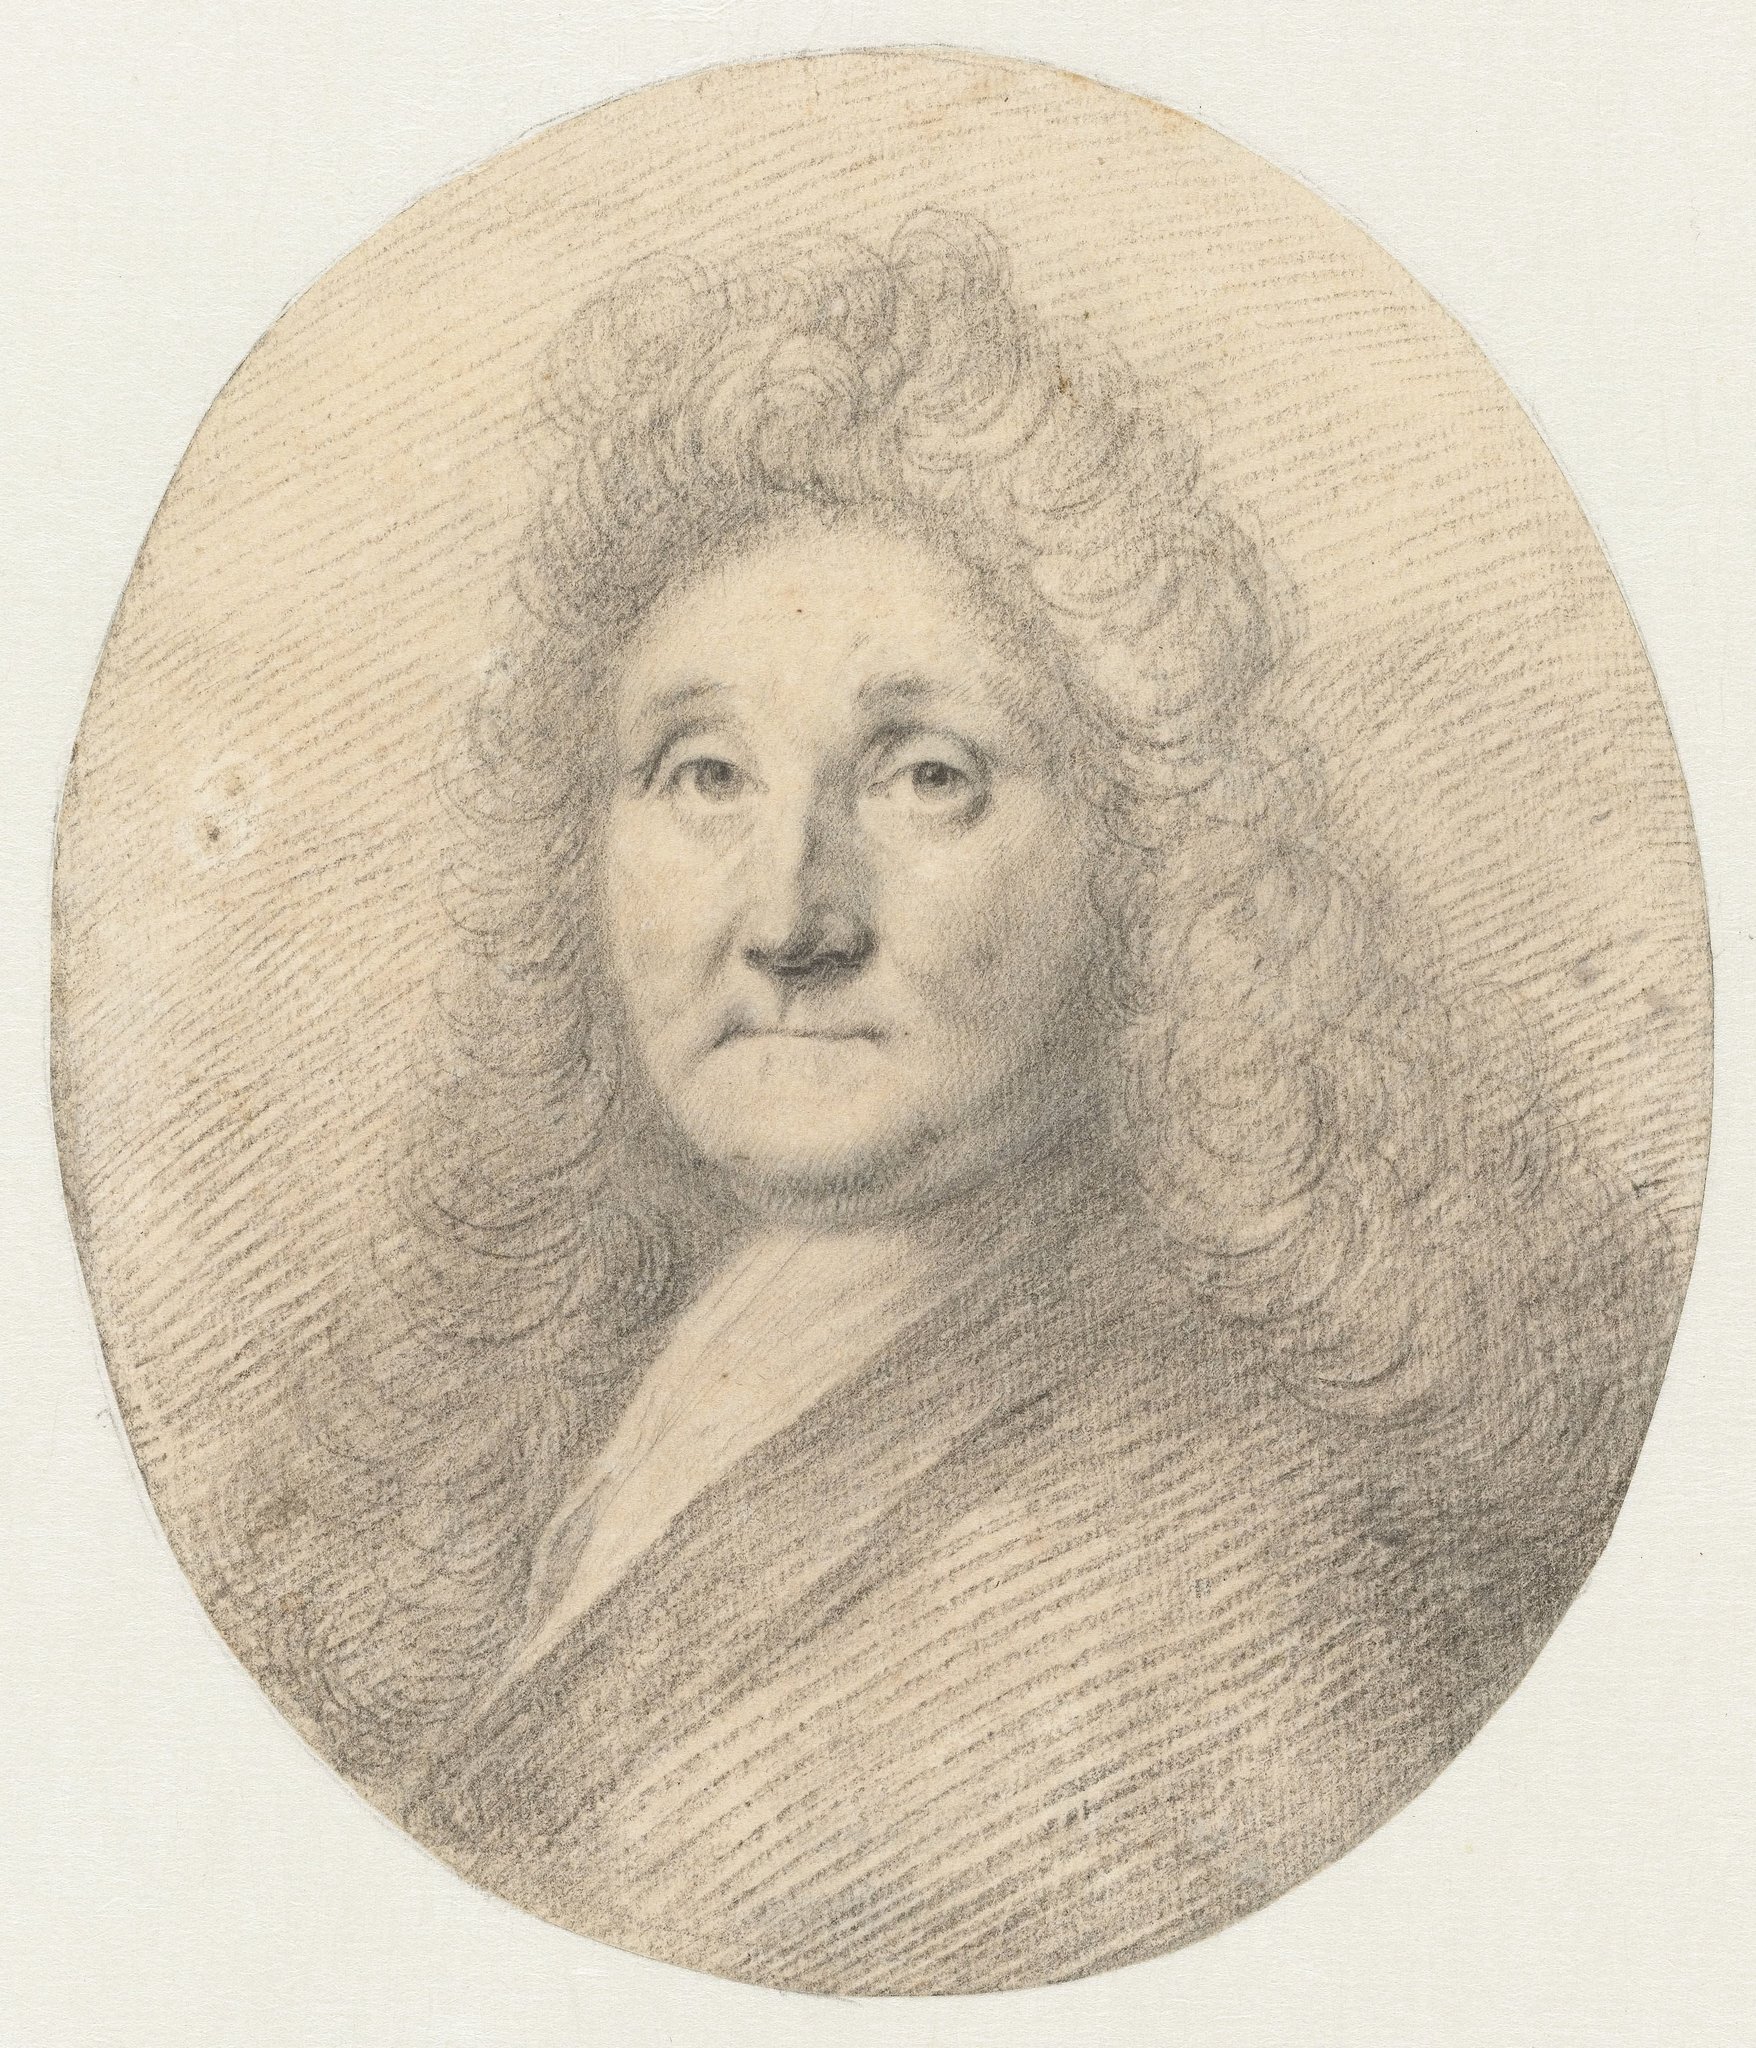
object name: drawing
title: Zelfportret van Ludolf Bakhuysen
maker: ludolf bakhuysen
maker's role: draughtsman, print maker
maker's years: 1631-1708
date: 1690-1708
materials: chalk, paper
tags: amsterdam, print maker, draughtsman, ludolf bakhuysen, historical persons, portrait, self-portrait of painter, portrait, self-portrait of artist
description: Zelfportret van Ludolf Bakhuysen, borstbeeld naar rechts, aanziend.